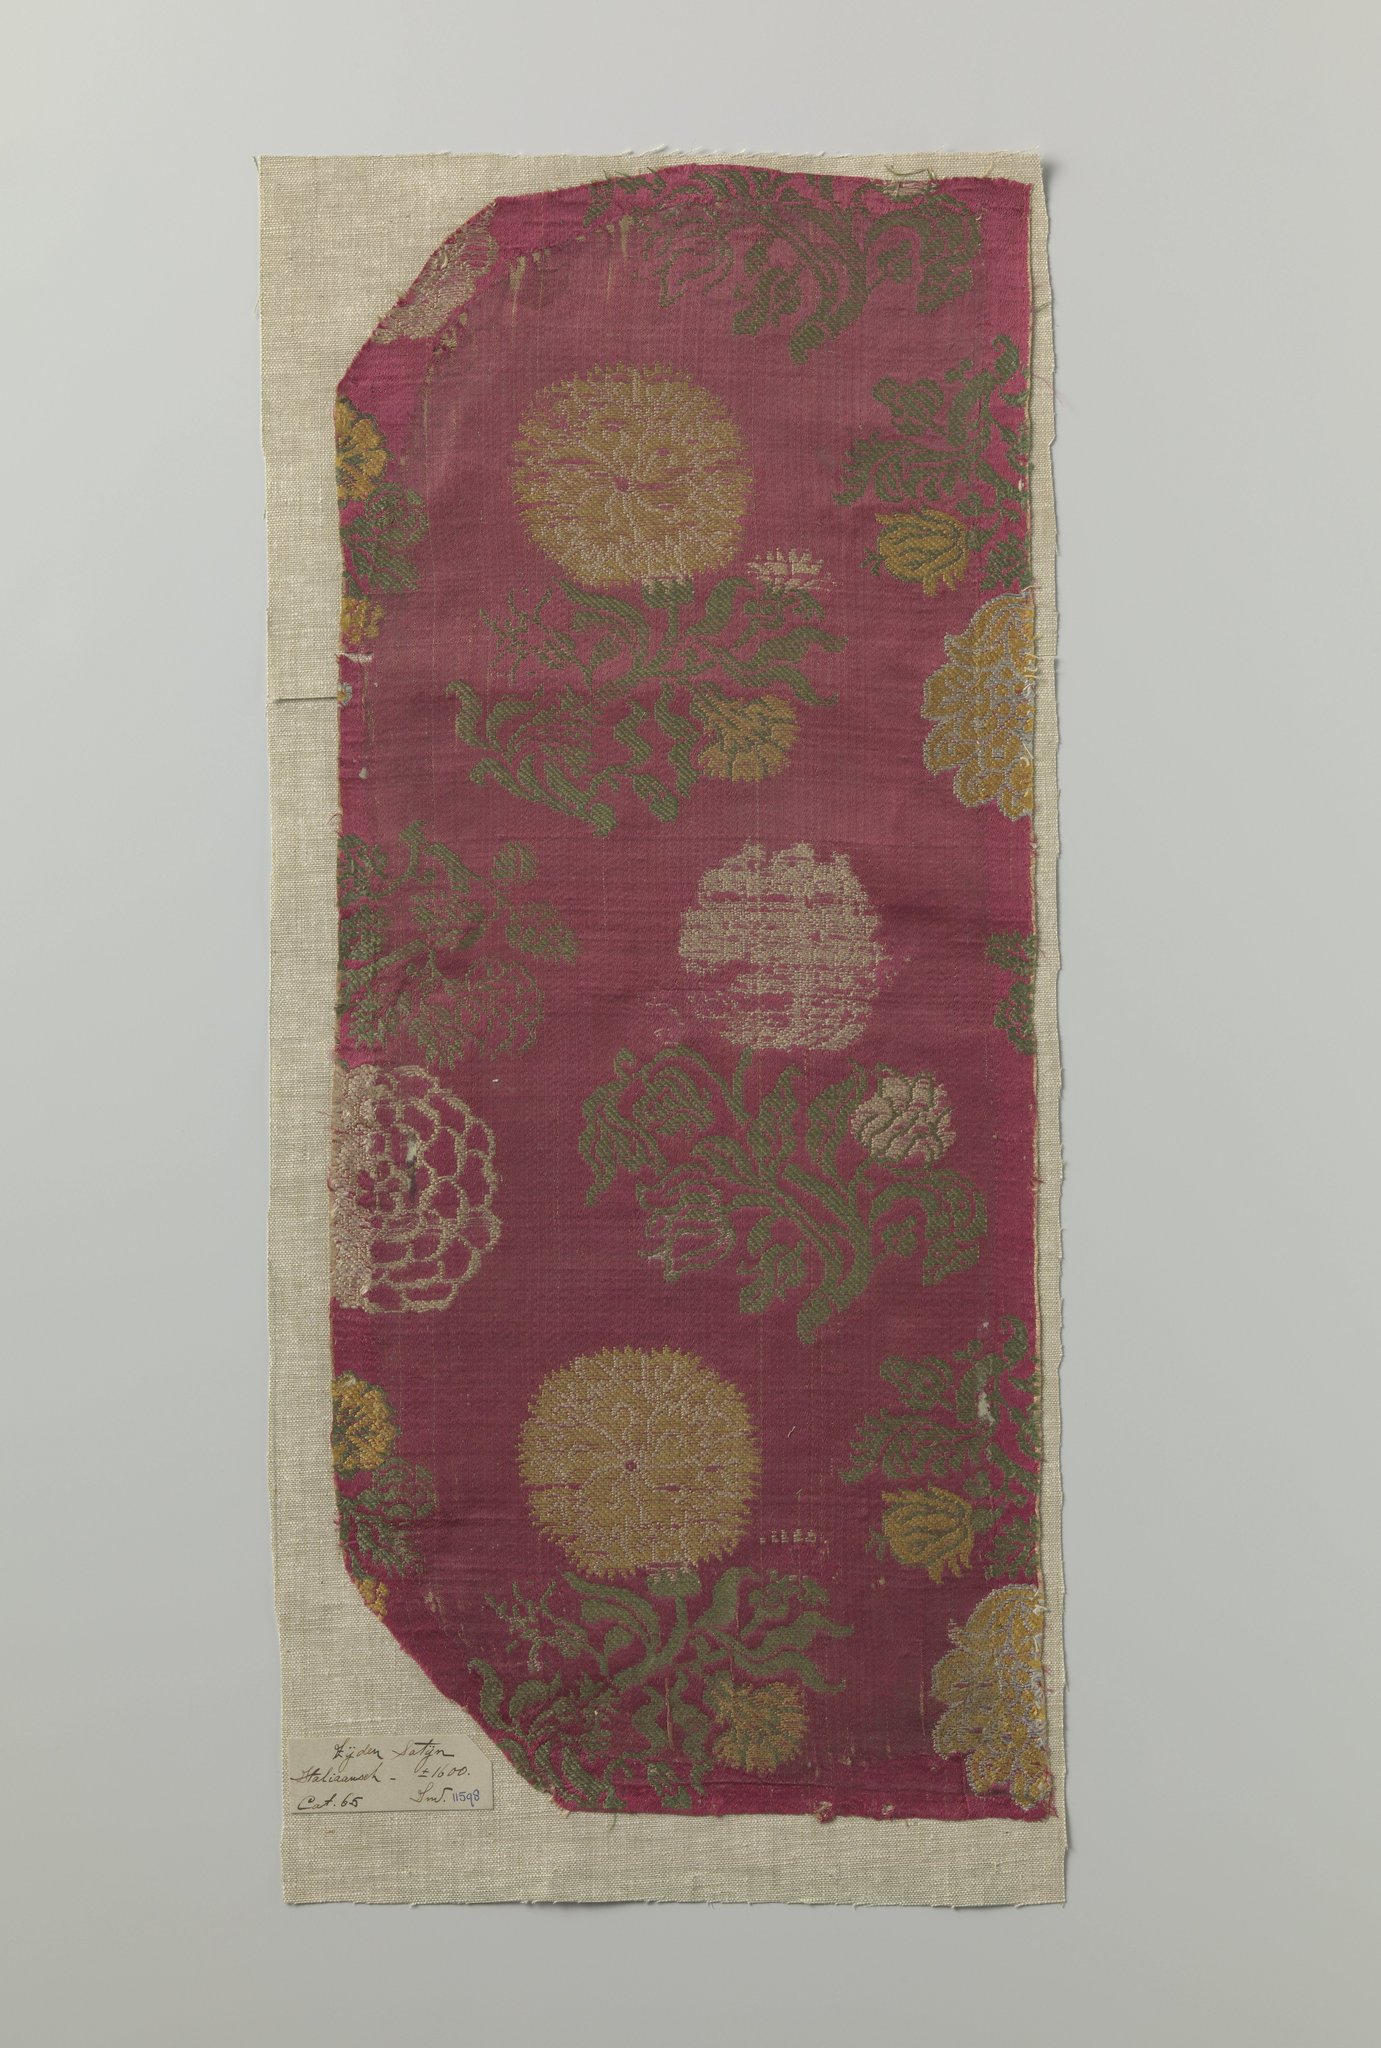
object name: zijdesatijn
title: Fragment rode gebrocheerd zijdesatijn met bloemmotieven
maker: Anonymous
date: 1590-1650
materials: silk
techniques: brocade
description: Fragment van rode zijde met patroon in wit, groen en geel van grote bloemen aan afwisselend naar rechts en links buigende bladstengels.